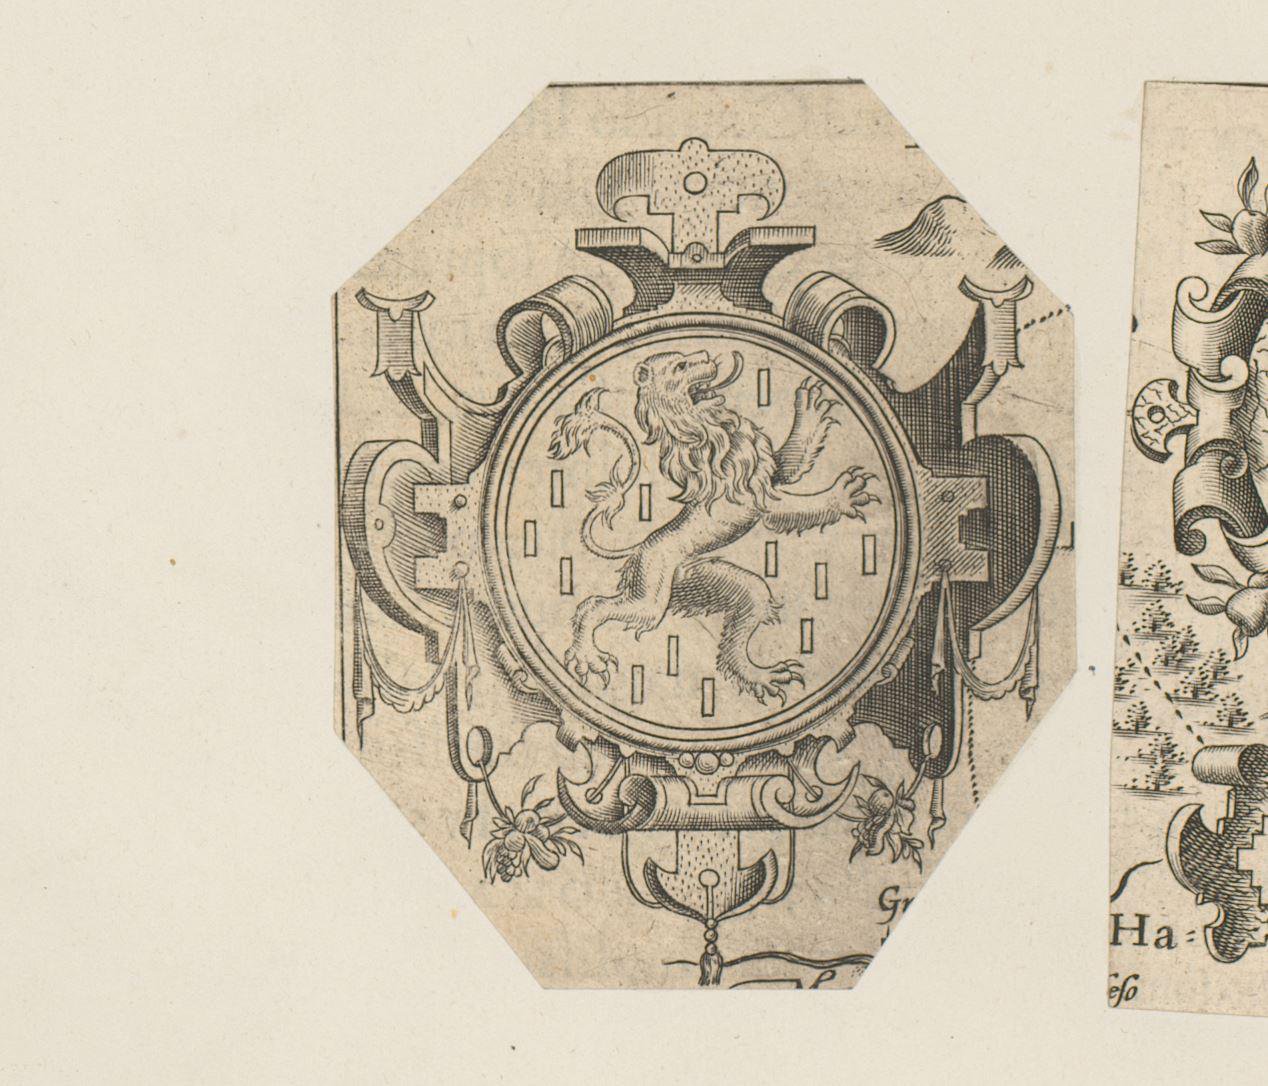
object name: ornament print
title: Burgundiae Comitatus Recentiss Descriptio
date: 1579-1580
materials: paper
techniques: engraving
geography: antwerp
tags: coat of arms (as symbol of the state, etc.), ornament ~ cartouche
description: Ronde cartouche met het wapen van Bourgondië (een klimmende leeuw). Het betreft een ornament van een kaart van Bourgondië. De prent maakt deel uit van een album.